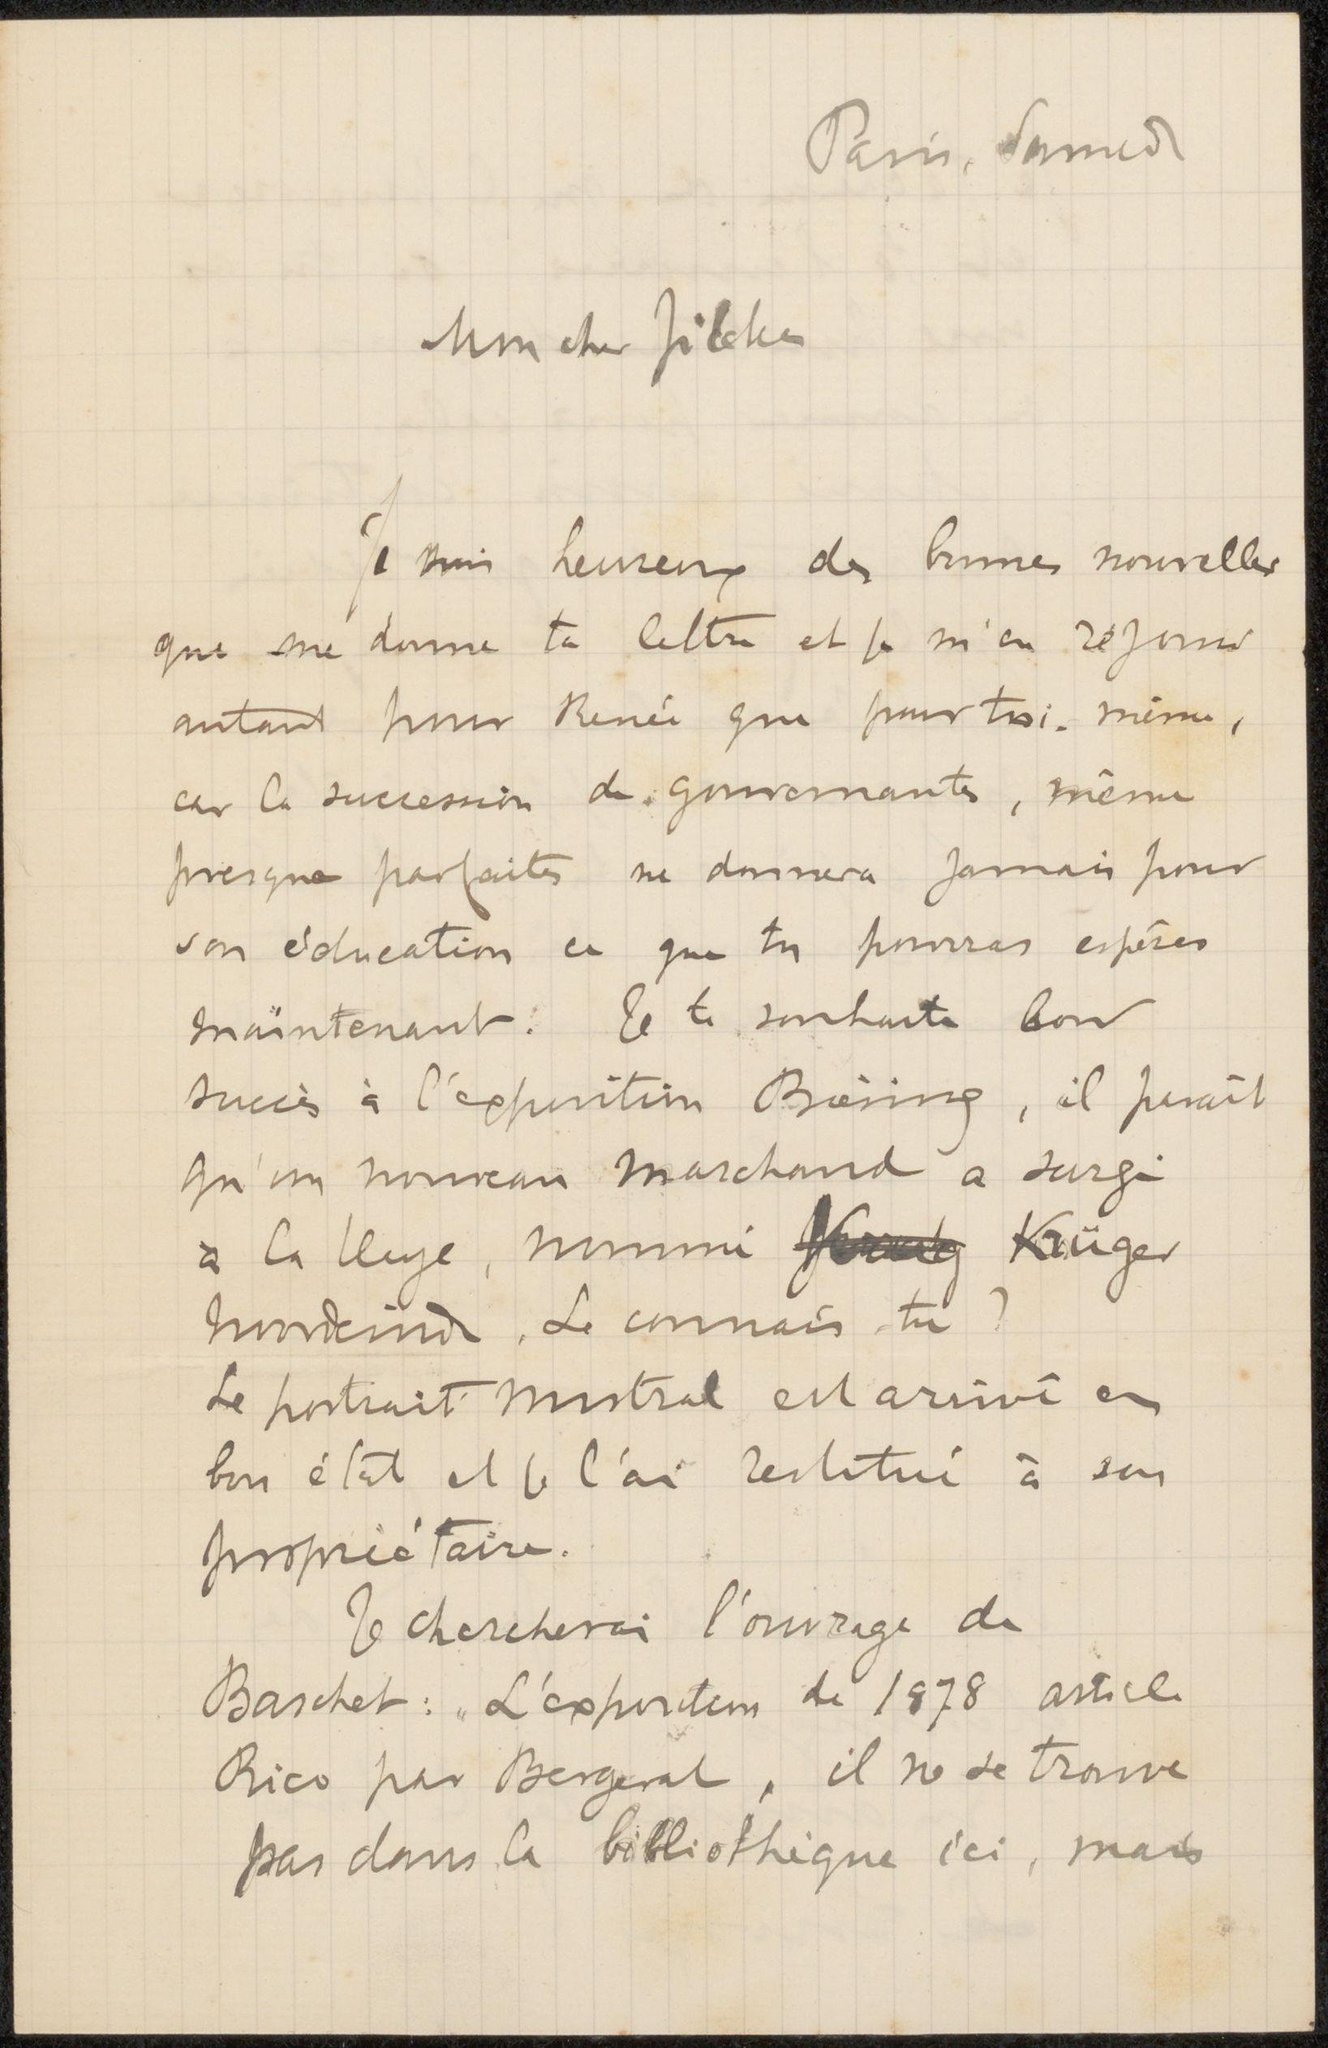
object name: letter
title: Brief aan Philip Zilcken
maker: charles destrée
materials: ink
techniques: pen, writing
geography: paris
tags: auctioneer, j.j. biesing, voorburg, renée hélène laure zilcken, frédéric mistral, the hague, painter, philip zilcken, exhibition ~ art, historical persons (portraits and scenes from the life)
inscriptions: collector's mark: ‘RPK’